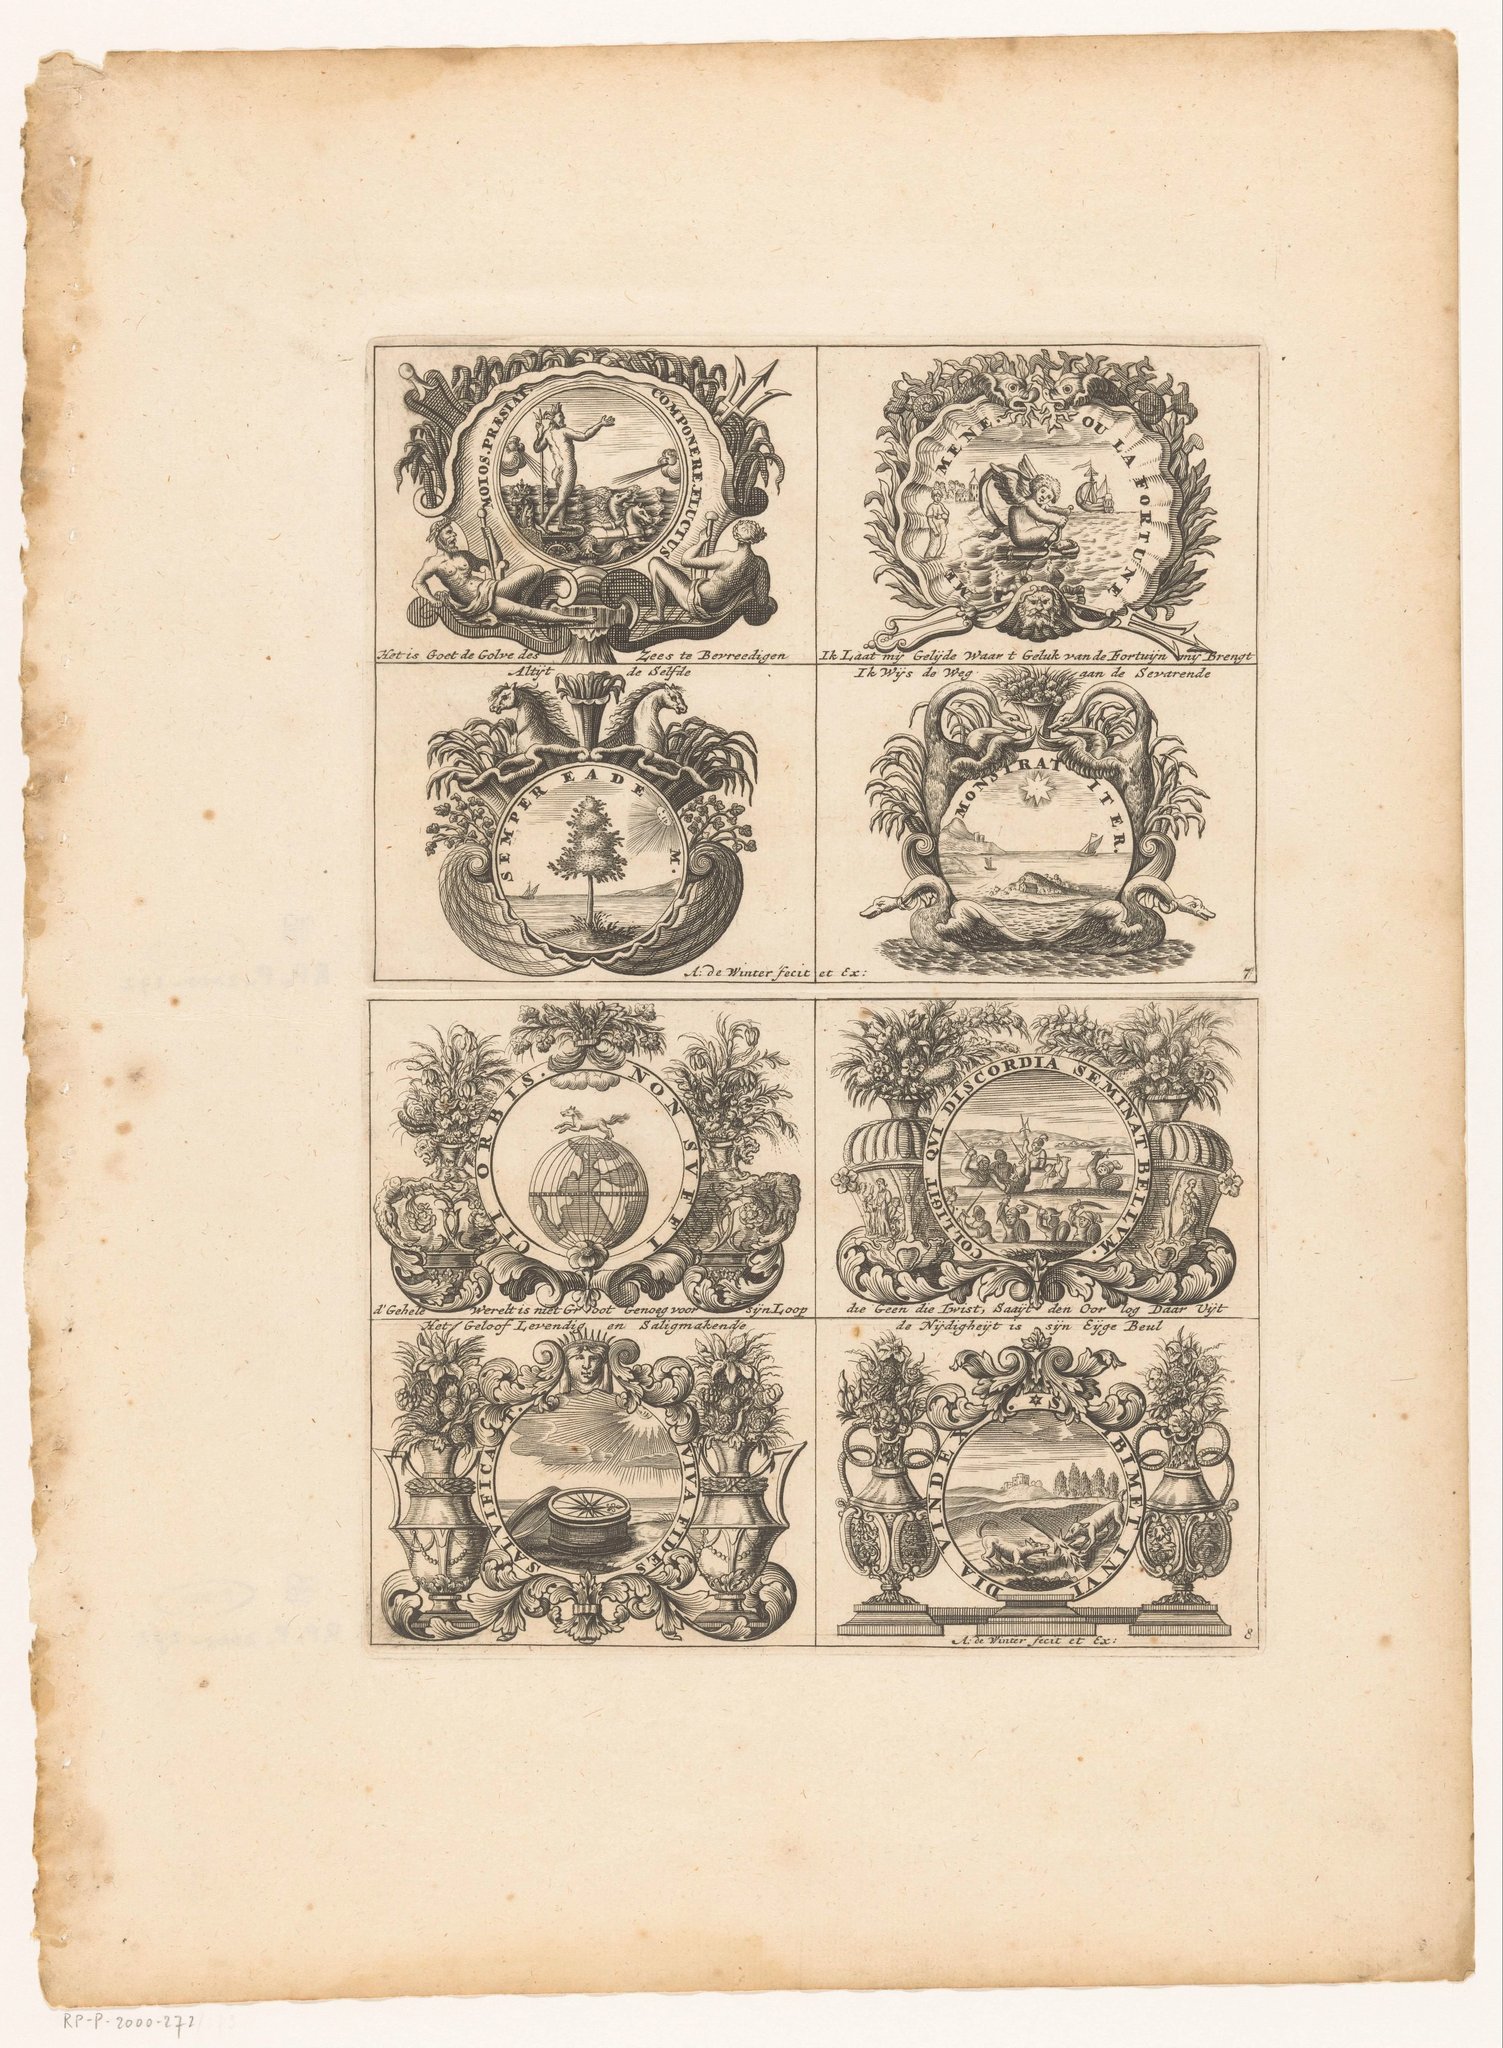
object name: print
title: Emblemata met Neptunus, Amor en een globe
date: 1697-1718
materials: paper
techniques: engraving, etching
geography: amsterdam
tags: (story of) neptune (poseidon), (story of) cupid, amor (eros), globe, abstract ideas and concepts (+ emblematical representation of concept)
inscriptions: collector's mark: Lugt 2228, collector's mark: Lugt 2760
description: Tweemaal vier emblemata met Nederlandse tekst en Latijns motto op een blad. Boven: Emblemata met Neptunus, Amor, een boom aan het water en de Noordster. Onder: Emblemata met een paard op een globe, strijdende mannen in harnas, een kompas en twee vechtende honden.